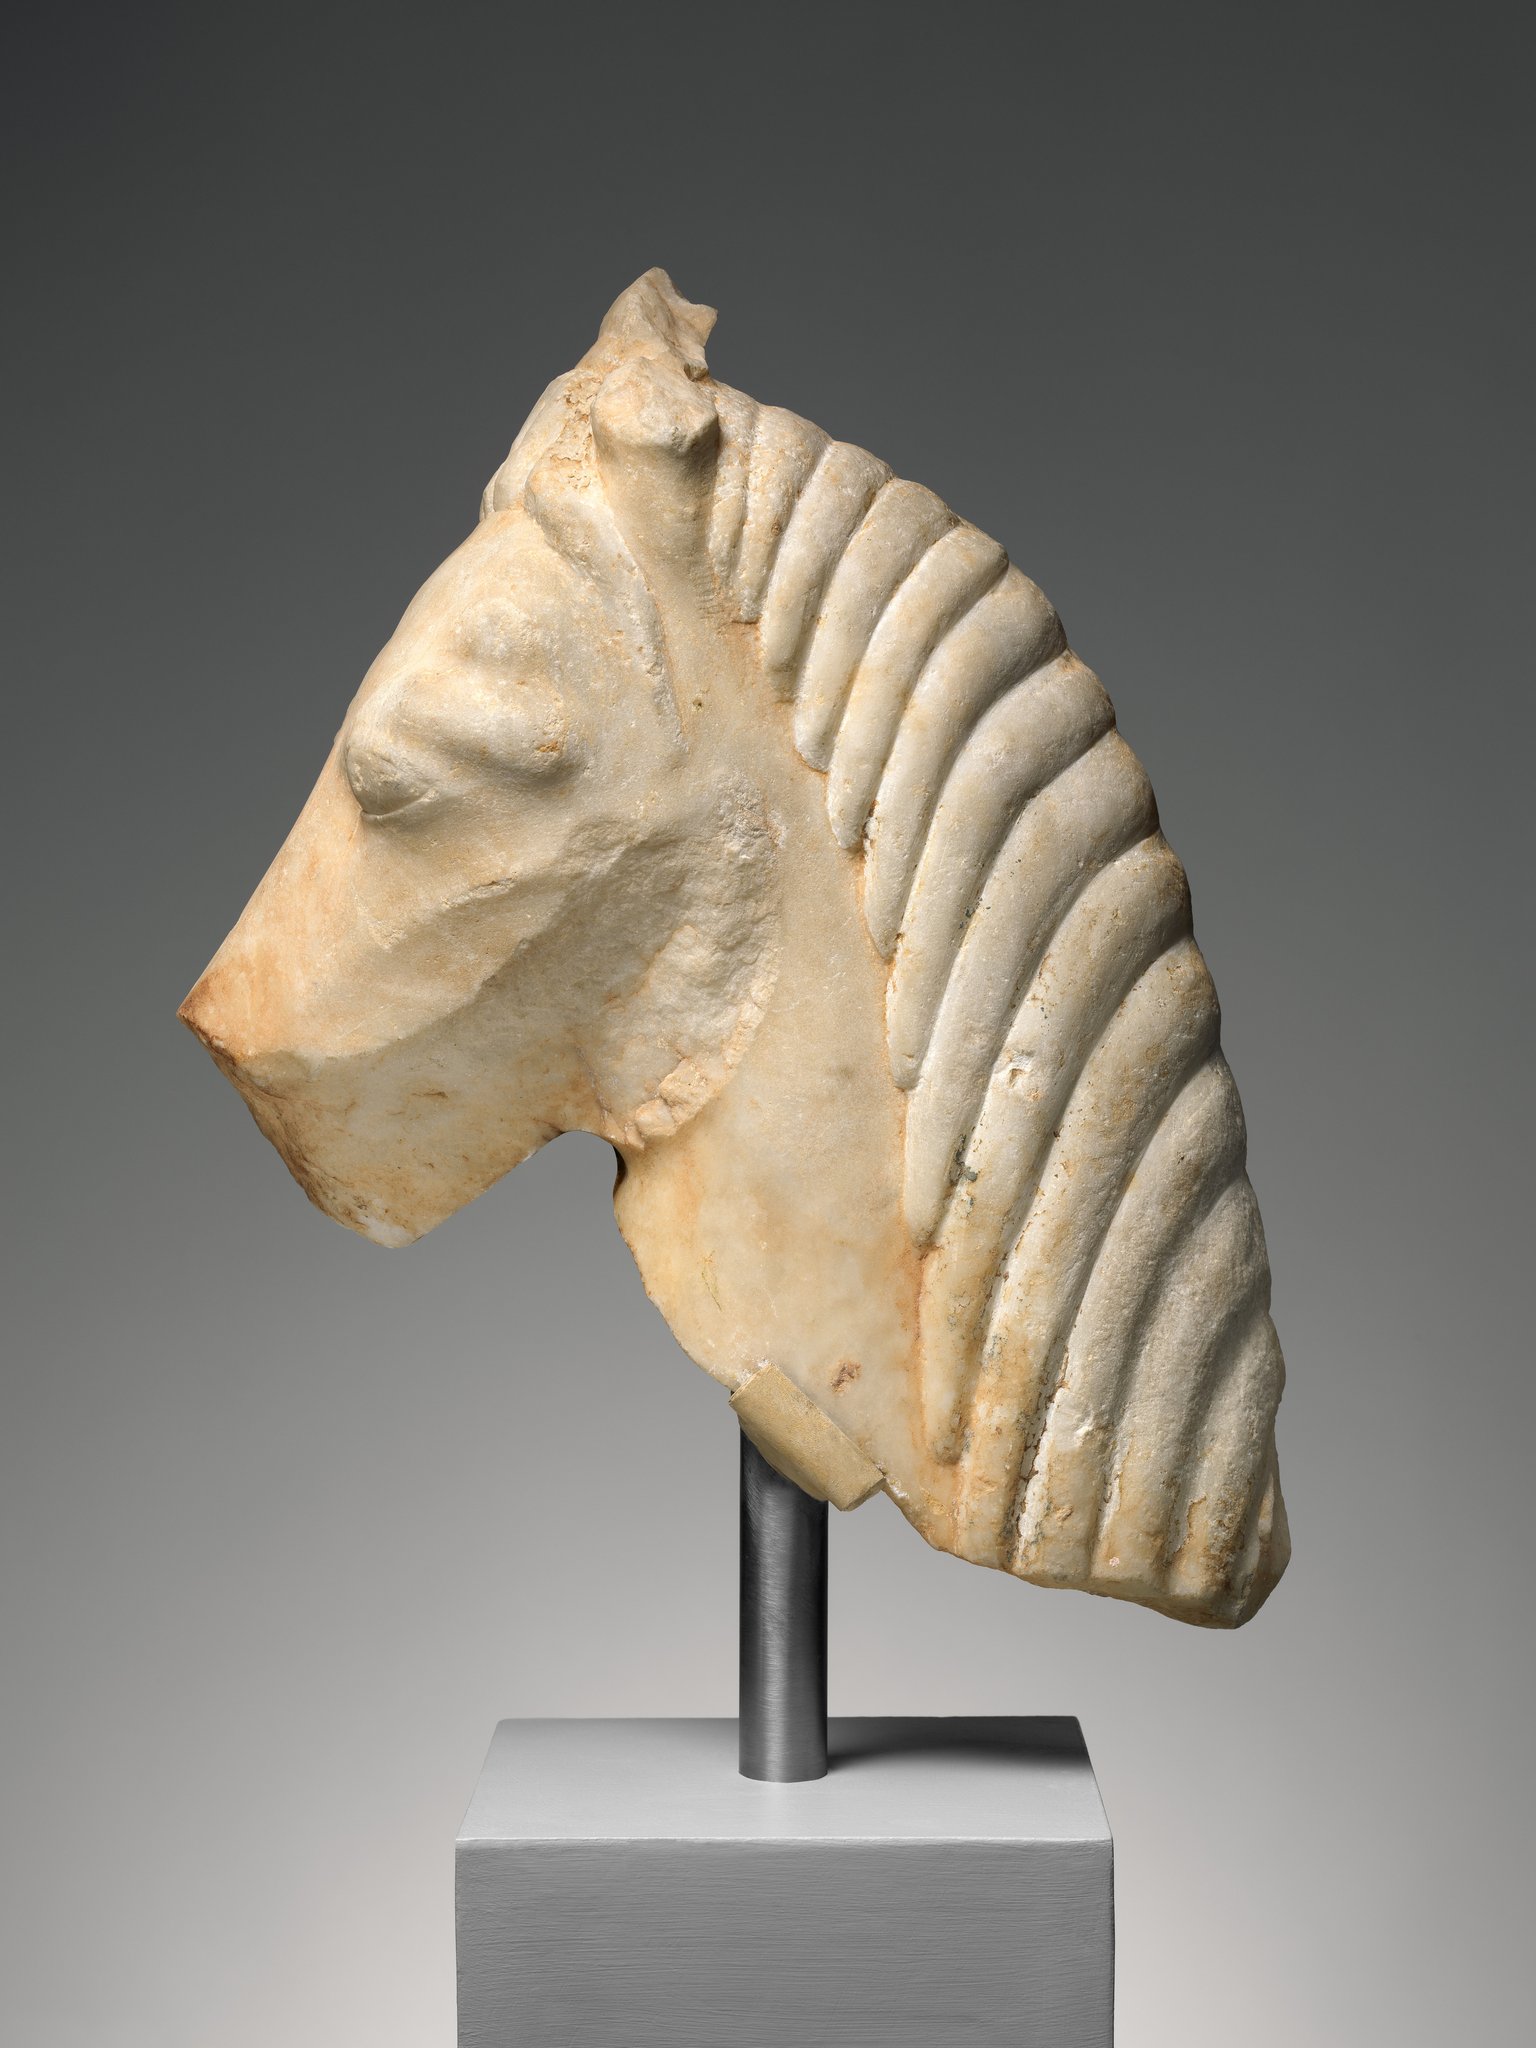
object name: head of a horse, fragmentary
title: Marble head of a horse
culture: greek, attic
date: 550-501 BCE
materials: marble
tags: horses